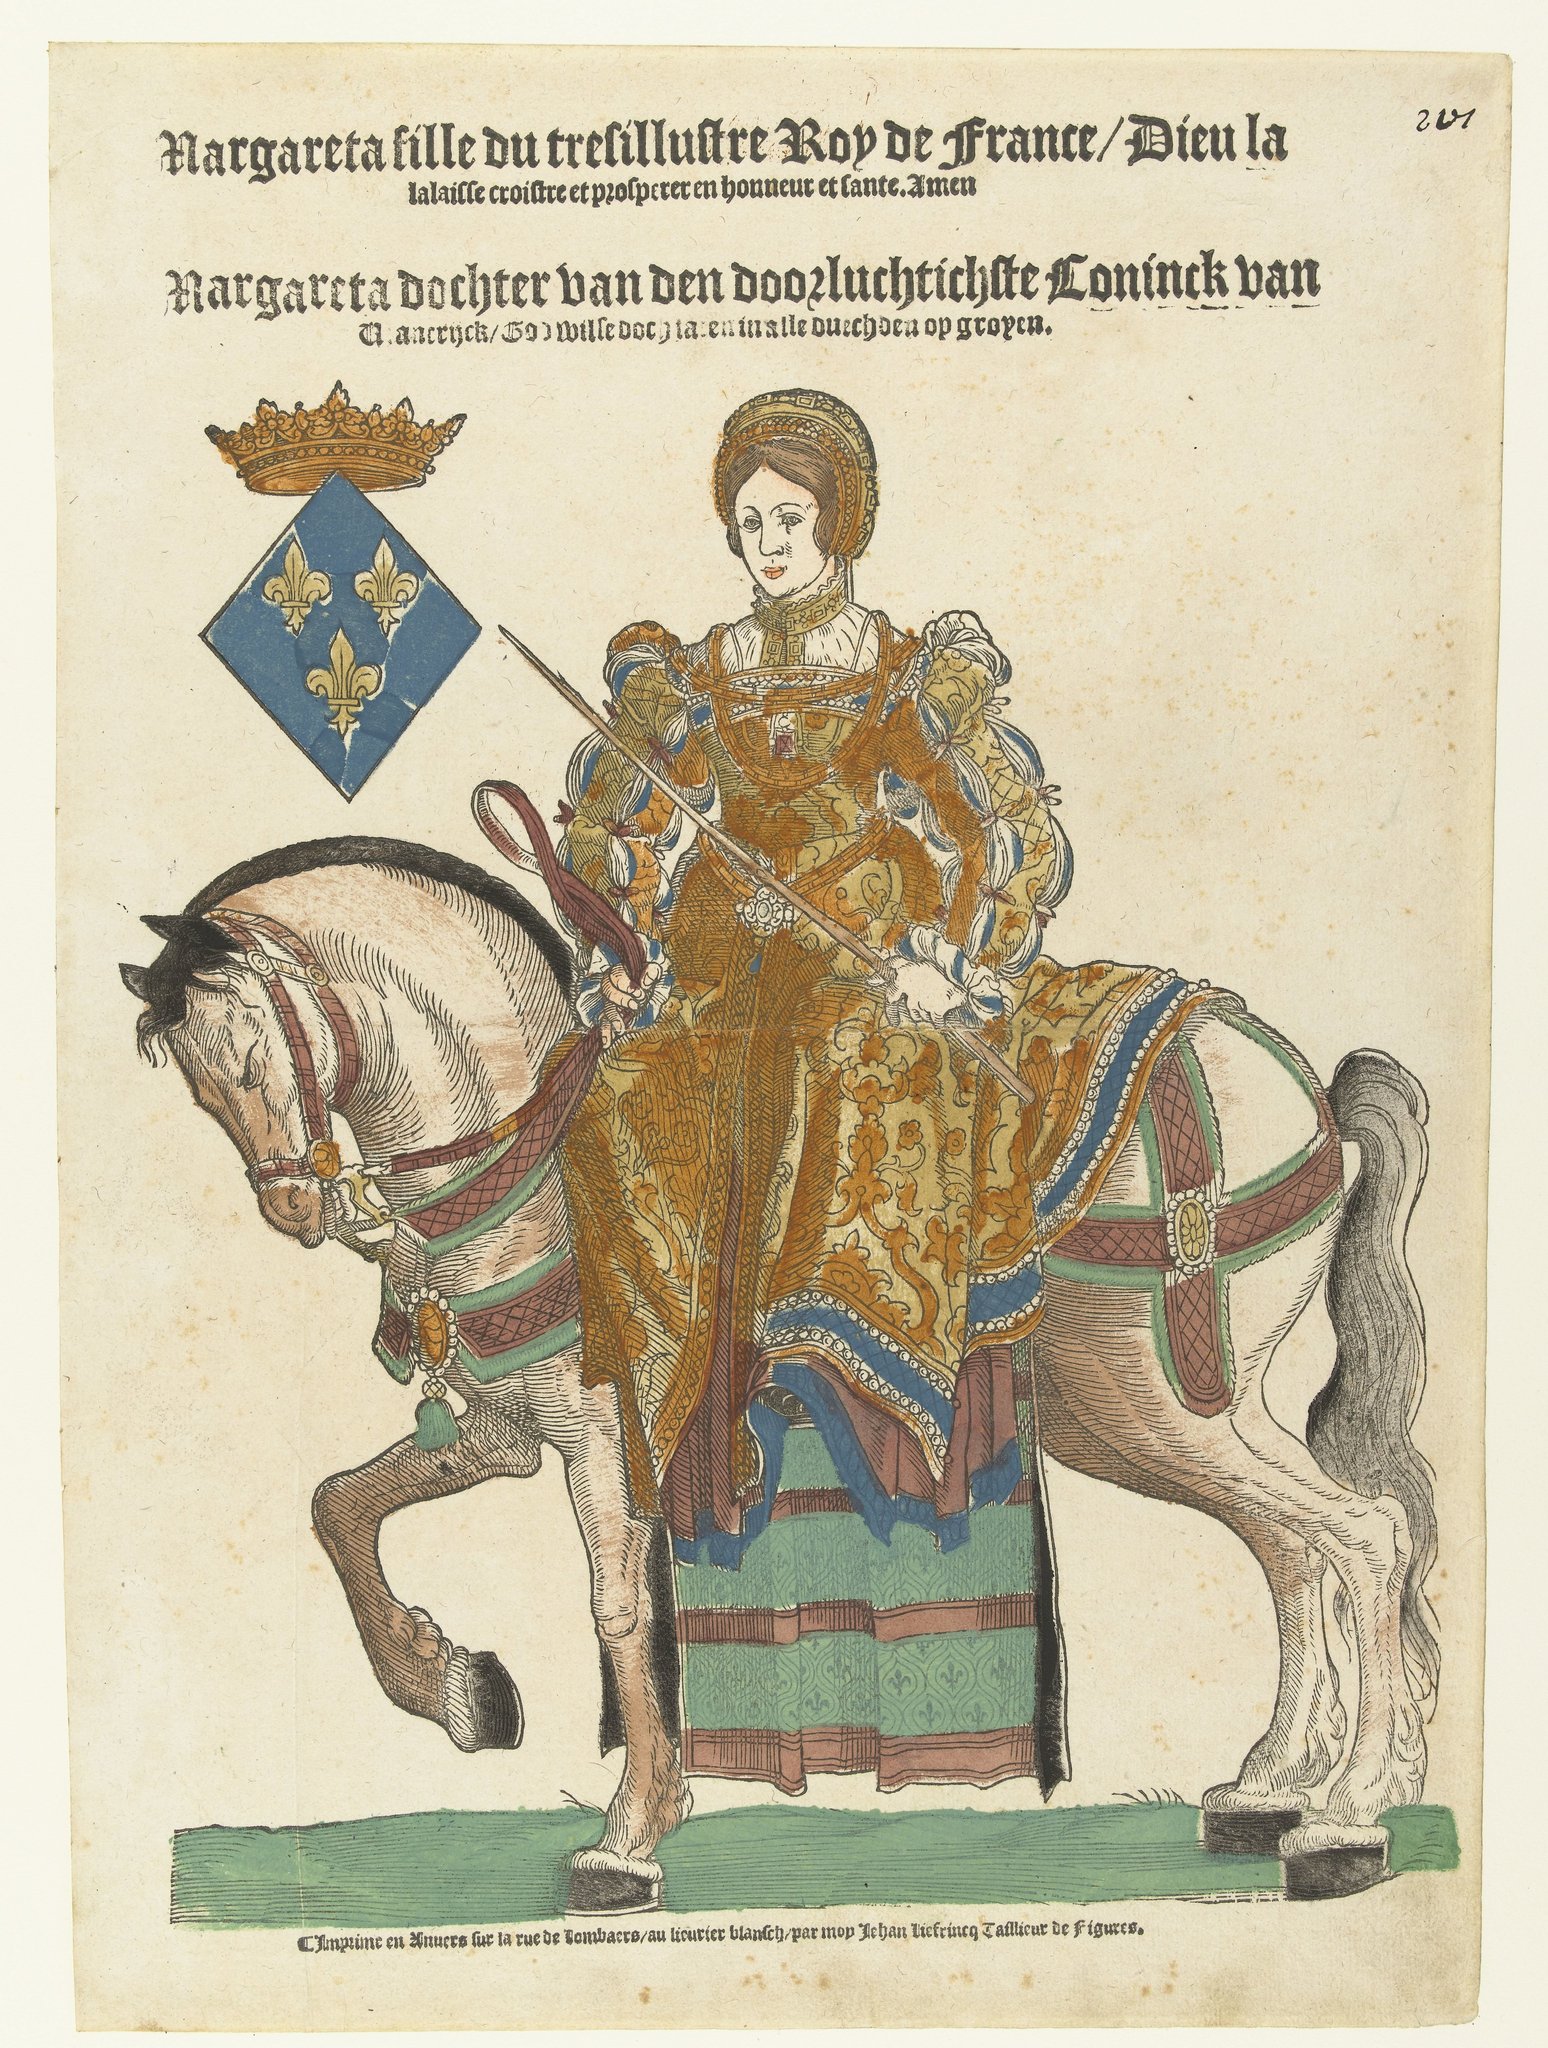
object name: print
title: Portret van Margaretha van Valois te paard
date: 1539-1559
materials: paper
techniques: hand coloring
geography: antwerp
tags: equestrian state-portrait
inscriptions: number: ‘201’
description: Margaretha van Valois in dameszit te paard. Linksboven ruitvormige Franse wapen met kroon, twee regels tekst in het Frans en twee in het Nederlands.